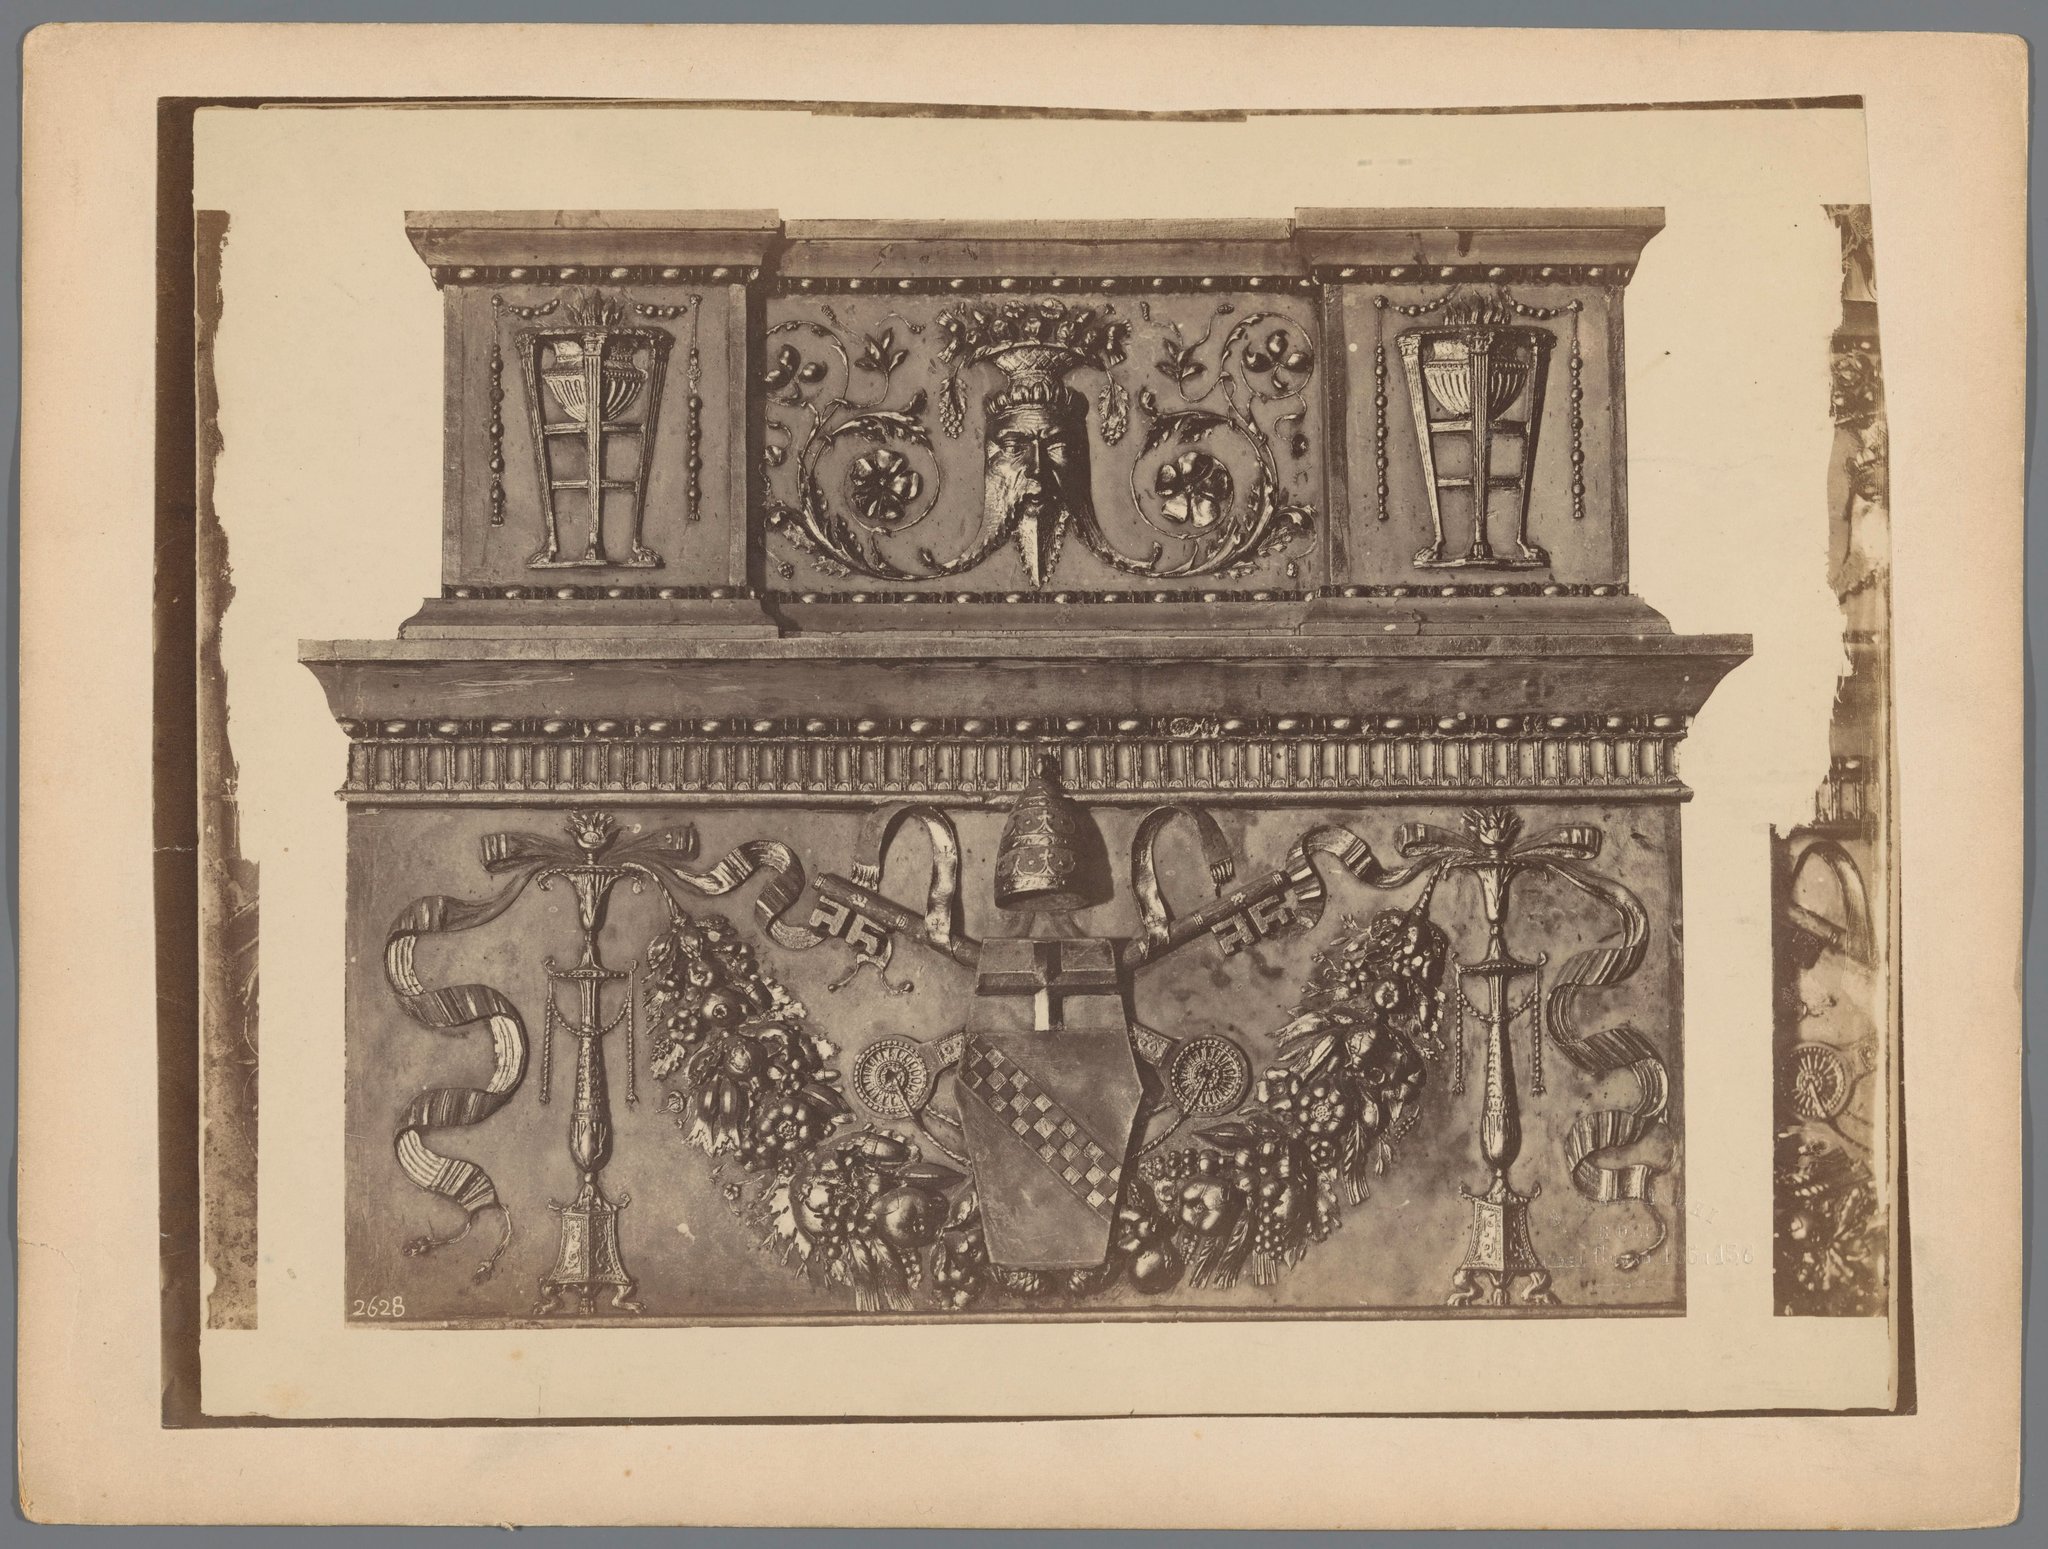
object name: photograph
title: Reliëf met het wapen van Vaticaanstad, een guirlande en een maskerkop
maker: enrico verzaschi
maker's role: fotograaf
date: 1875-1900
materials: cardboard, photographic support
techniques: albumen print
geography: italy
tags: coat of arms (symbol of sovereignty), insignia of the pope, e.g. tiara, ornament ~ festoon, garland, sculpture (+ relief ~ sculpture), italy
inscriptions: collector's mark: Lugt 3937, number: ‘2628’, name: ‘E. VERZASCHI ROMA via del Corso 135 a 136’